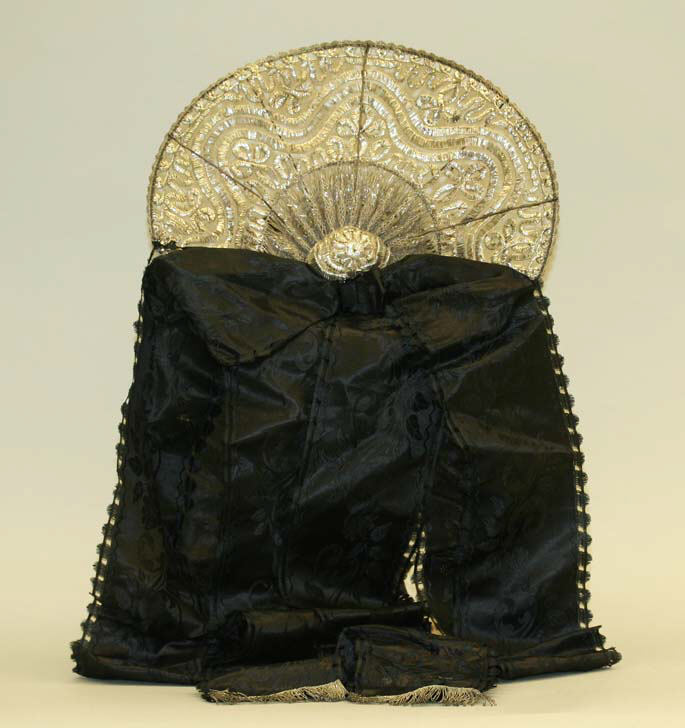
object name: headdress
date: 1801-1900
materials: metal, silk